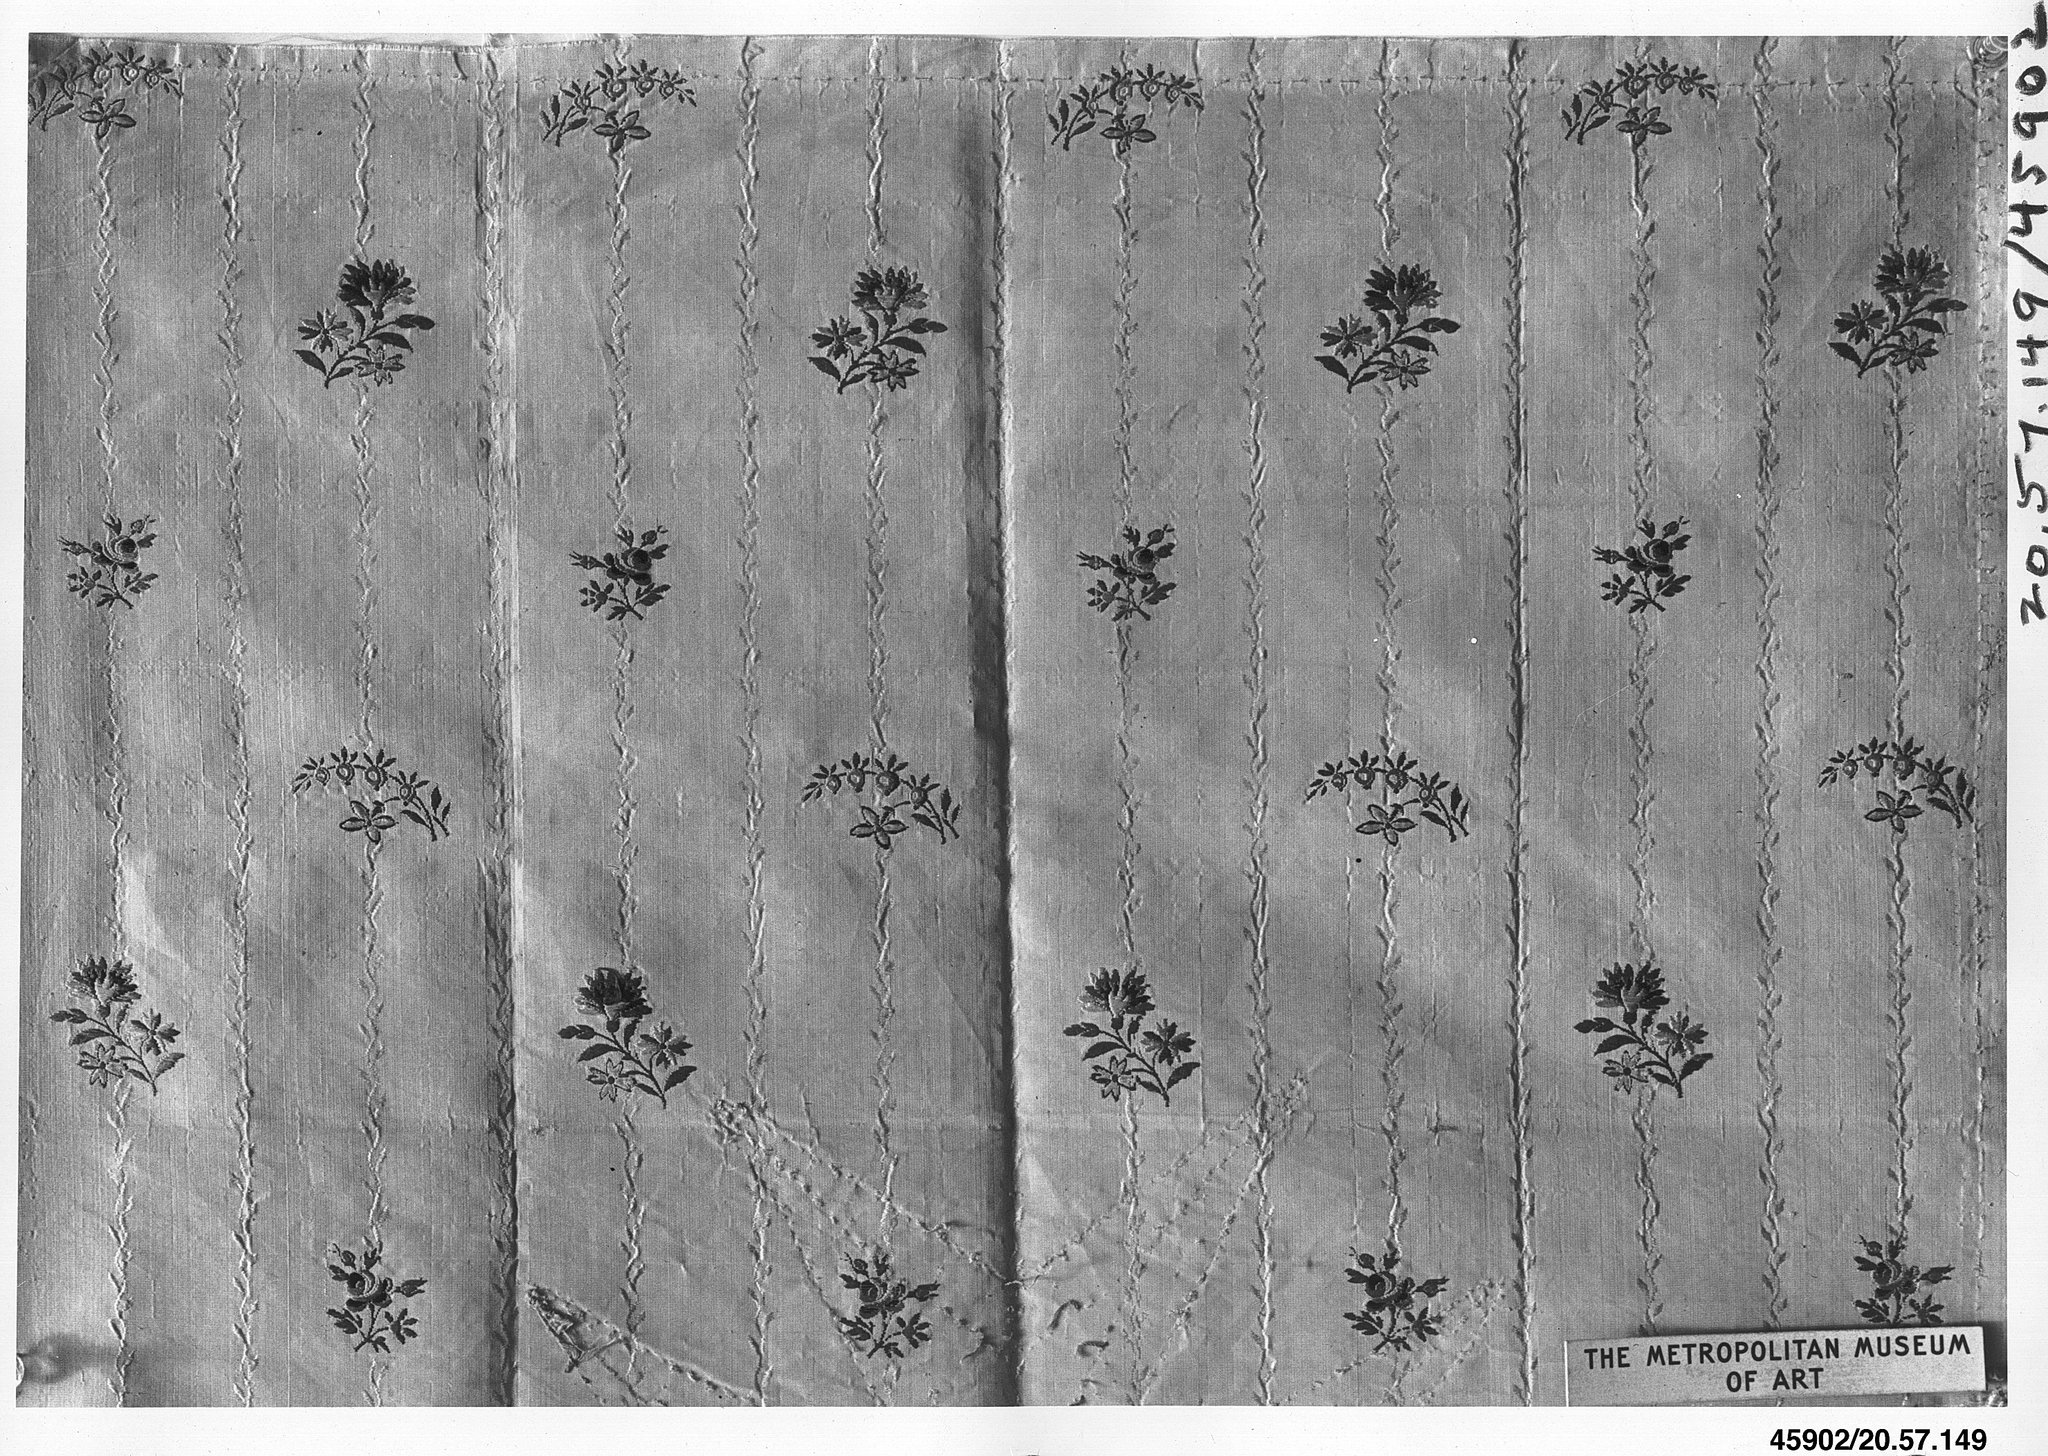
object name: piece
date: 1775-1800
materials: silk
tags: flowers,leaves